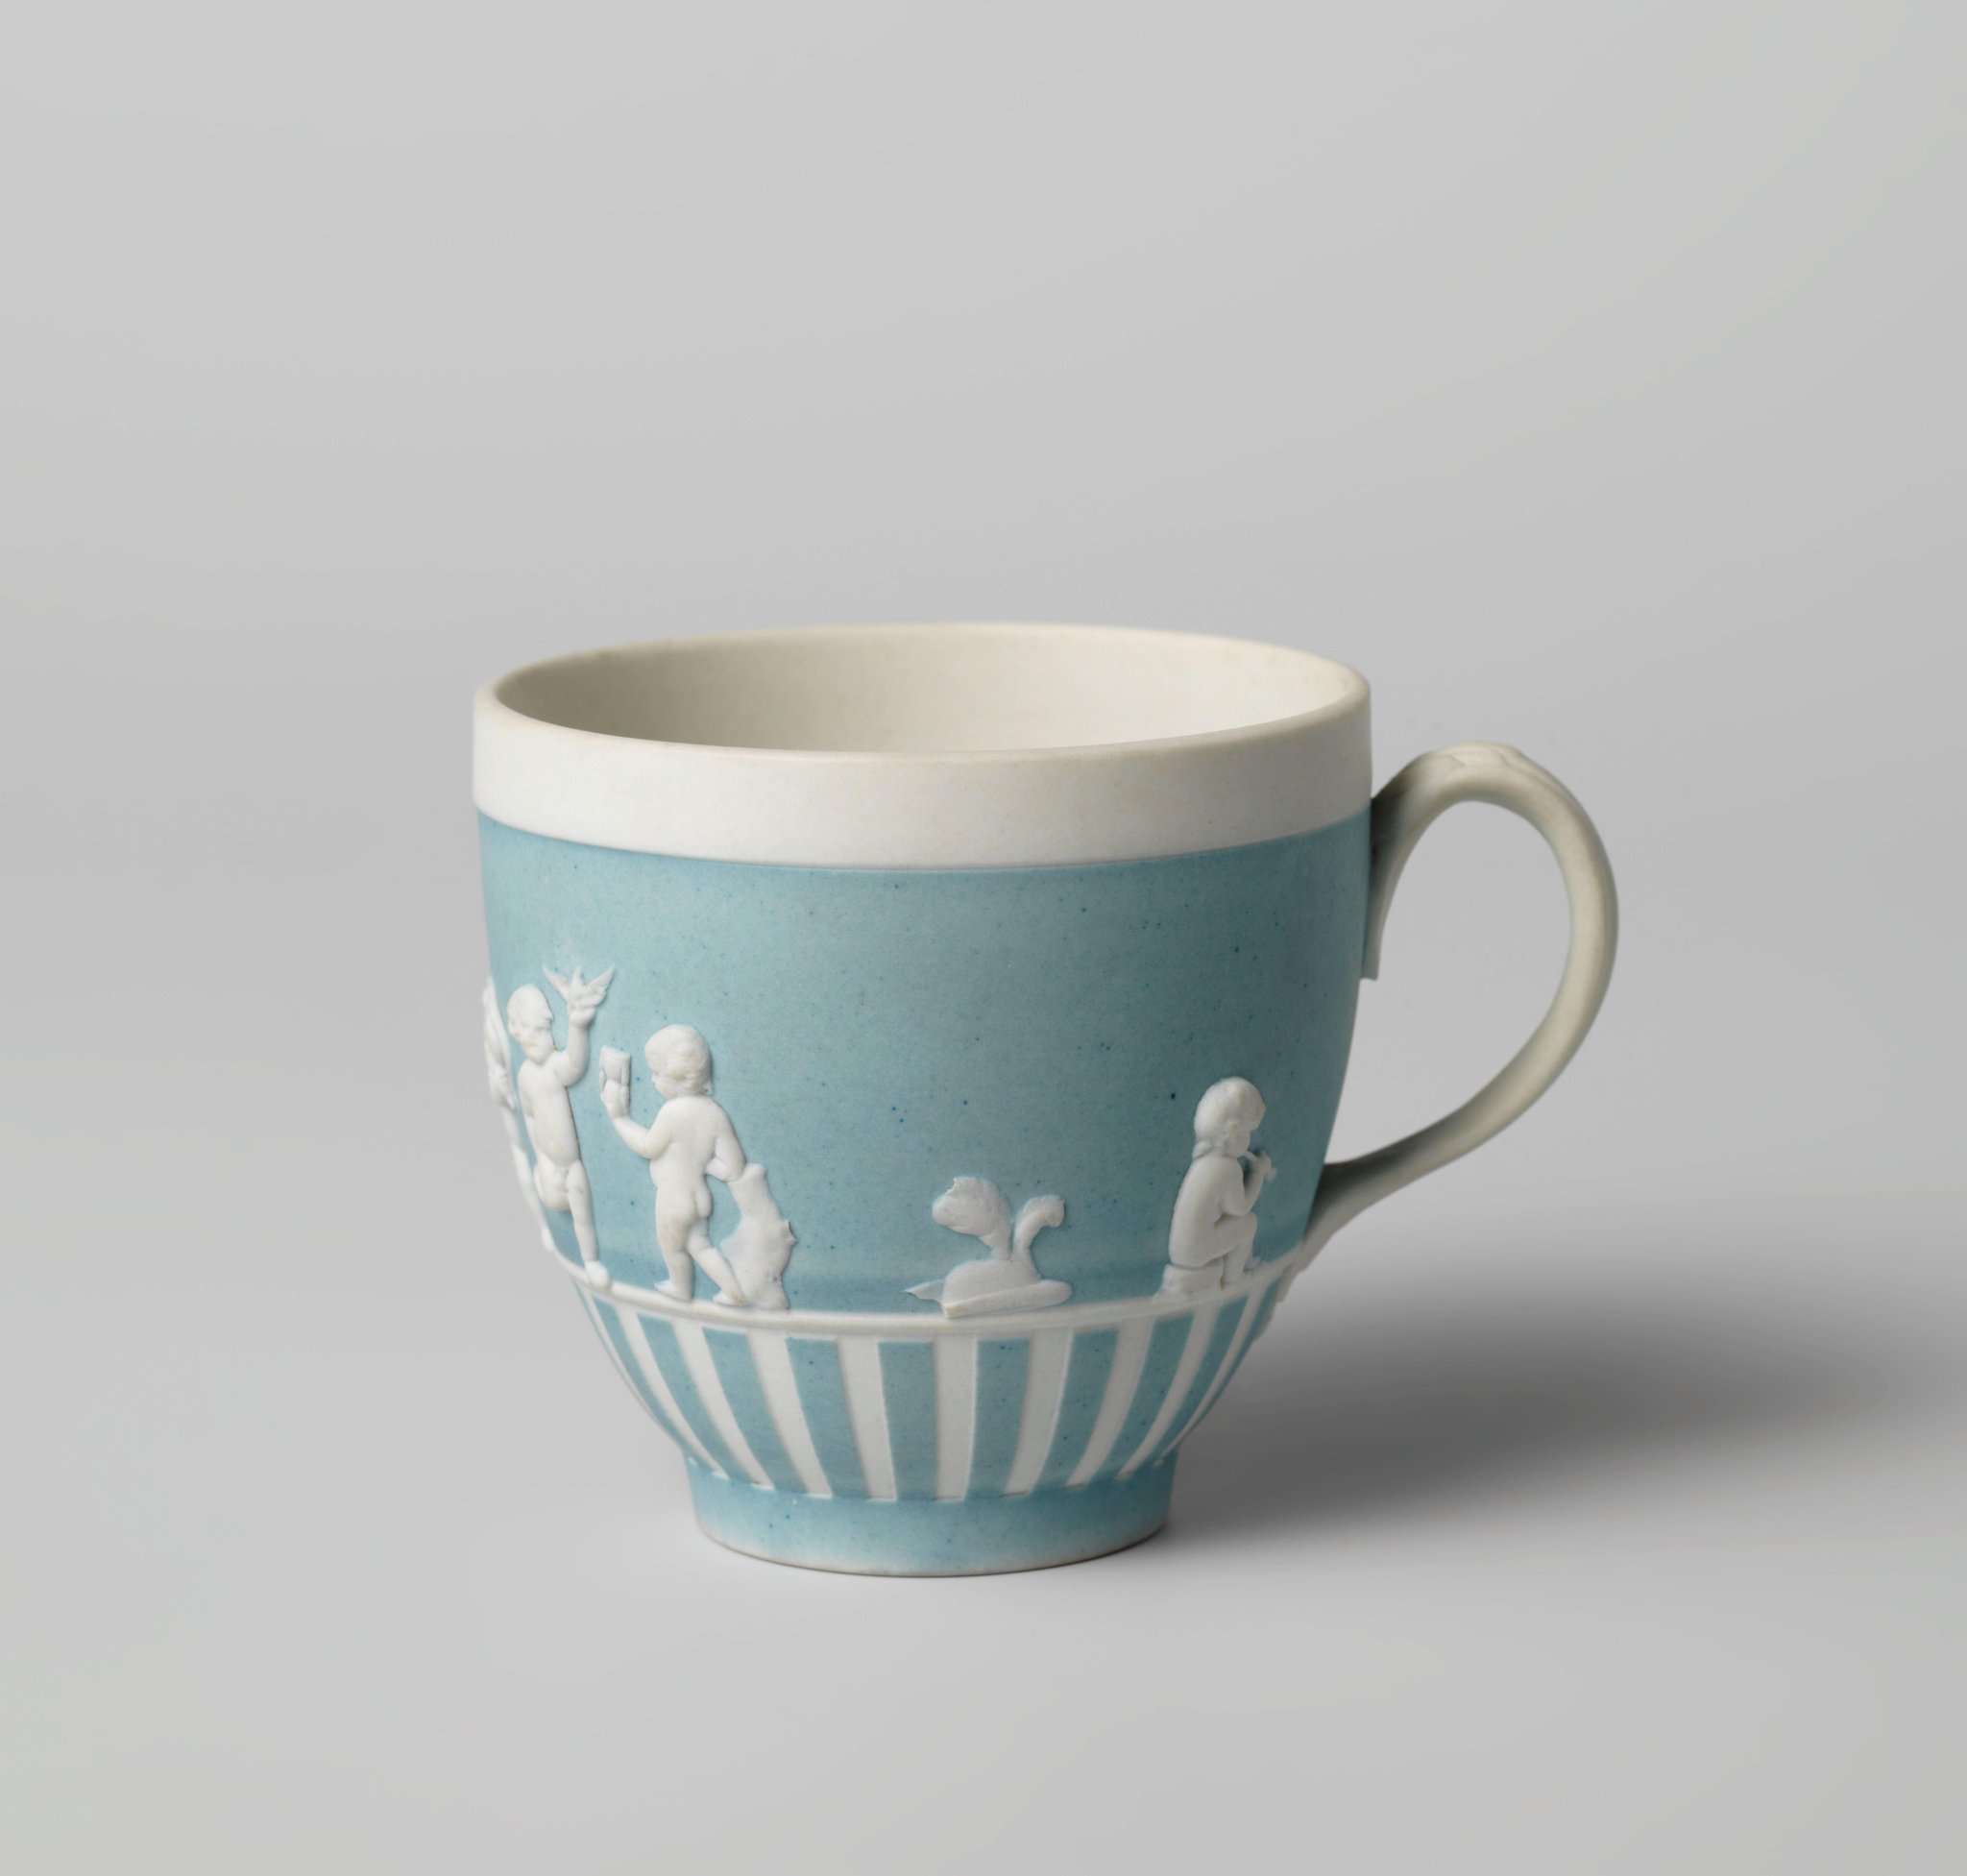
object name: cup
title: Kop van steengoed, Wedgwood Jasper ware.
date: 1790-1810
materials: stoneware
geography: england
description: Kop van steengoed. De kop heeft een C-vormig oor en een standring. De buitenkant heeft een blauwe fond waarop in reliëf witte decoraties zijn aangebracht. De decoratie bestaat uit spelende engelen boven verticale blauwe en witte banden. De kop is gemerkt en hoort bij een schotel met invnr. BK-NM-12471-B.